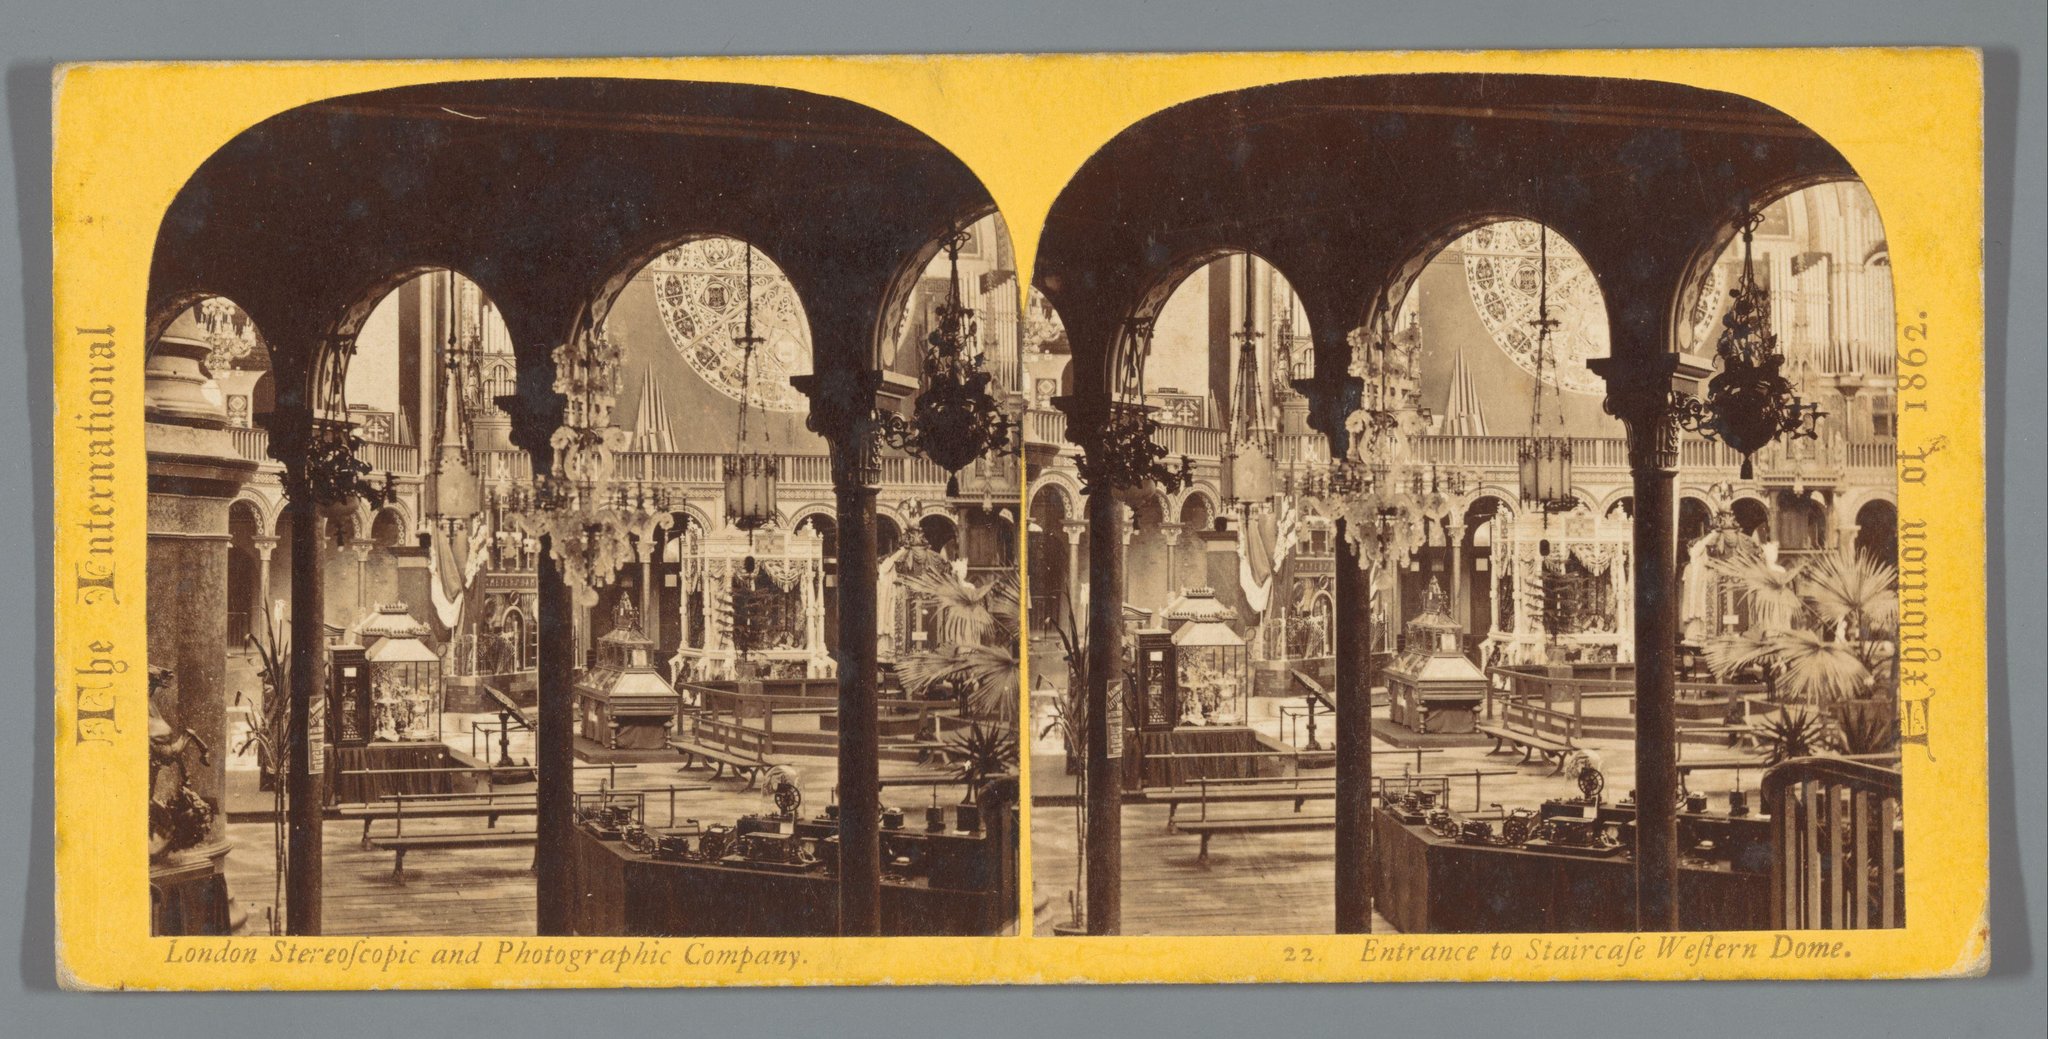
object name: stereograph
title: The International Exhibition of 1862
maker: william england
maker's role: fotograaf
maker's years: 1816-1896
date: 1862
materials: cardboard, paper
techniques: albumen print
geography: london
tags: world fair, world exhibition, interior of industrial structures (regardless of the materials processed or the products made, london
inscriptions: number: ‘22.’